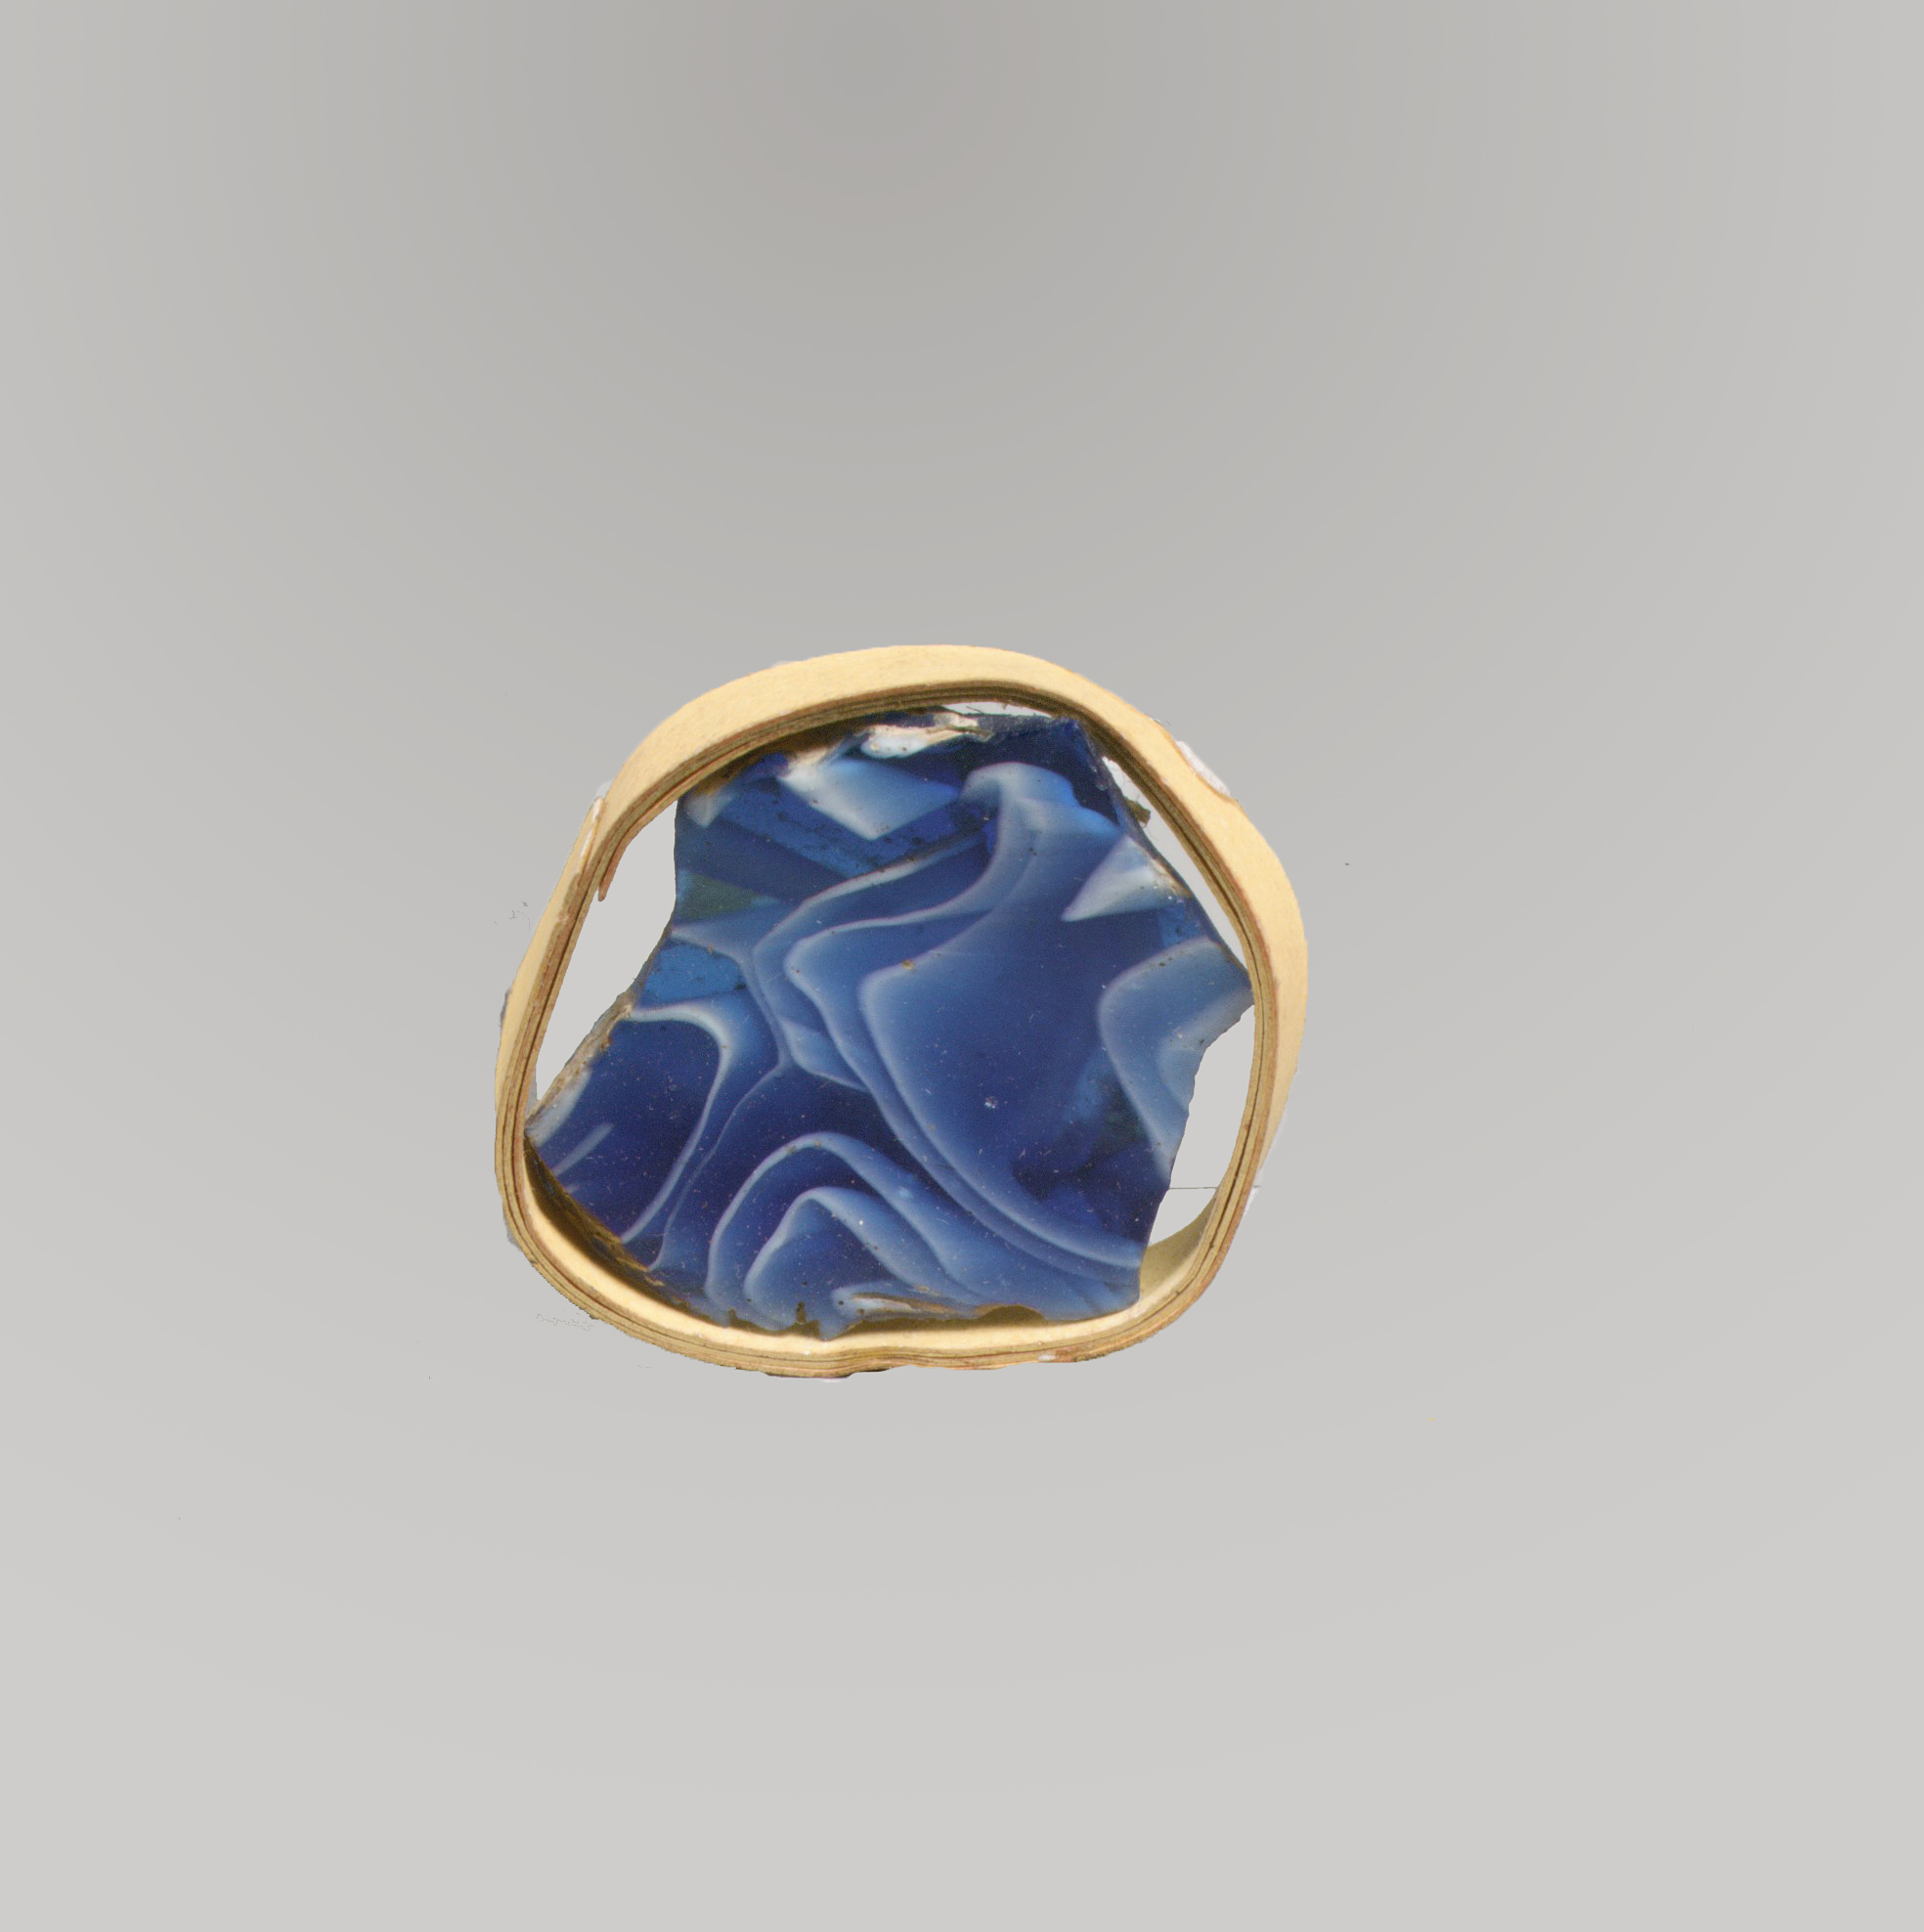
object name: fragment, mosaic bowl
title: Glass mosaic ribbed bowl fragment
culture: roman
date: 34 BCE-33 CE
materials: glass